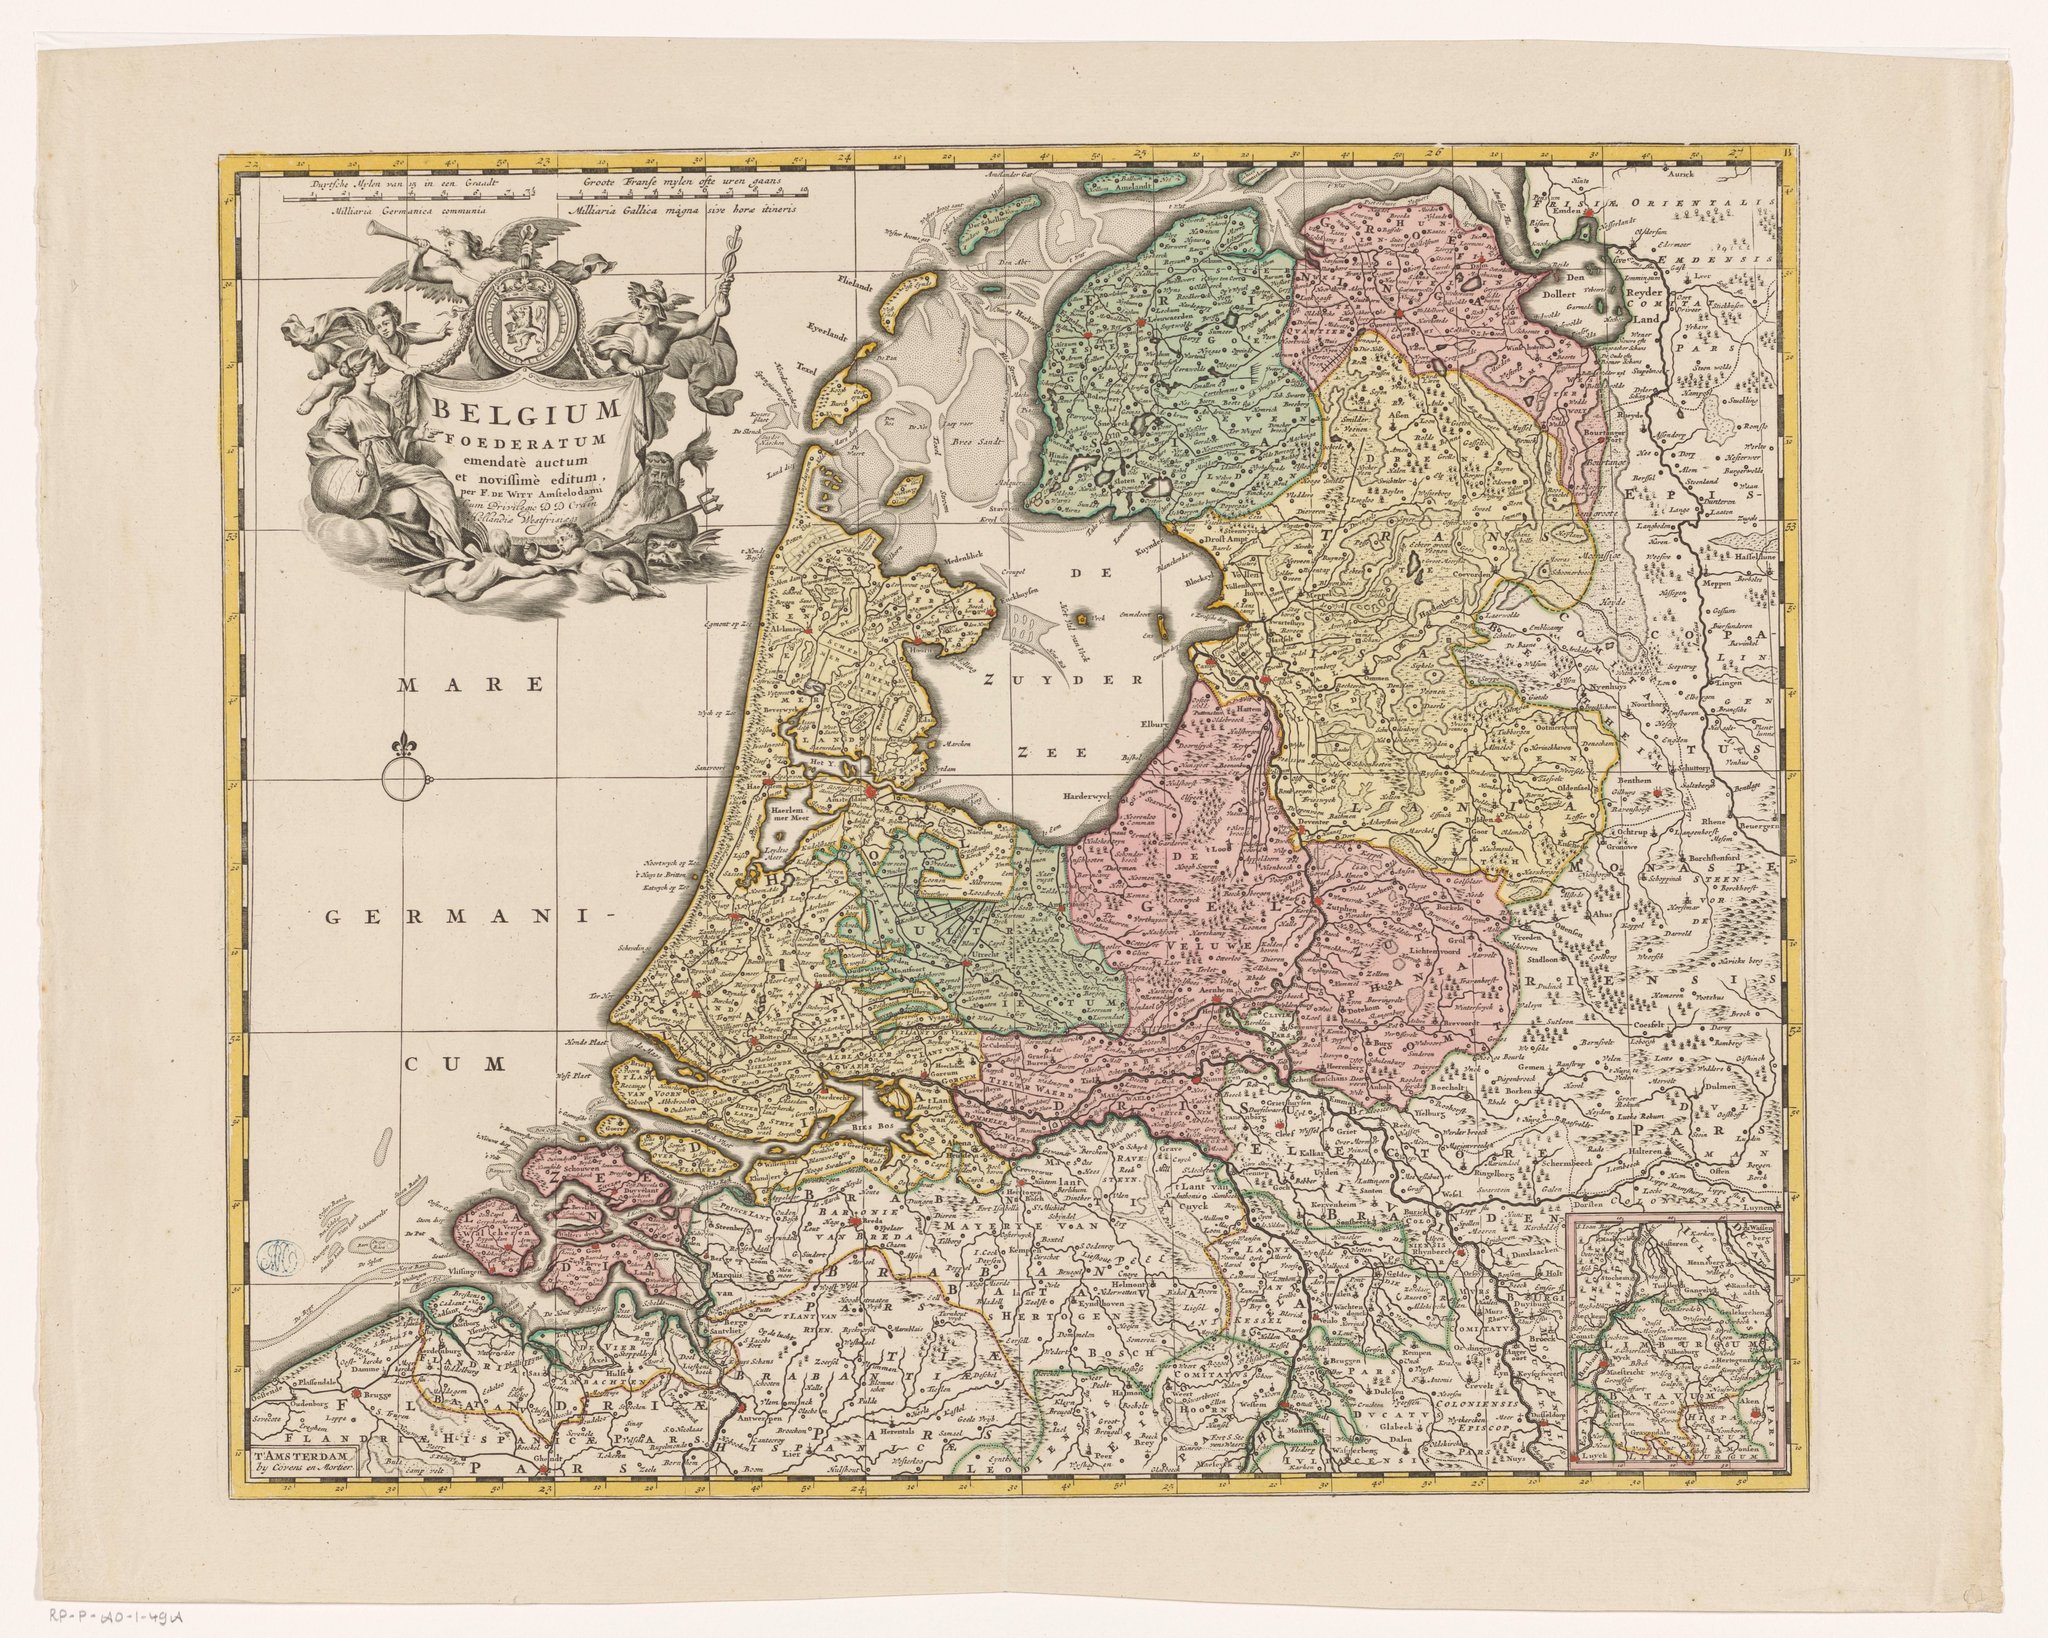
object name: print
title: Kaart van de Republiek der Zeven Verenigde Nederlanden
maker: frederik de wit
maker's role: print maker, printer, publisher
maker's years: 1629-1706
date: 1710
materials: paper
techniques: engraving, hand coloring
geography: amsterdam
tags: (story of) neptune (poseidon), coat of arms (as symbol of the state, etc.), maps of separate countries or regions, (story of) mercury (hermes), urania (one of the muses); 'urania' (ripa), fame; 'fama', 'fama buona', 'fama chiara' (ripa), netherlands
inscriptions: collector's mark: Lugt 2228, collector's mark: Lugt 195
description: Linksboven cartouche met titel en het wapen van de Republiek, daaromheen zijn verschillende figuren afgebeeld: Urania, Fama, Mercurius, Neptunus en een aantal putti. Rechtsonder een inzetkaartje van een deel van het huidige Limburg (deel dat destijds tot Staats-Brabant behoorde). Schaalstok linksboven: Duytsche mylen van 15 in een graadt / Milliaria Germanica communia, Groote Franse mylen ofte uren gaans / Milliaria Gallica magna sive hore itineris. De kaart is voorzien van een coördinaten-net en een gradenverdeling langs de randen.